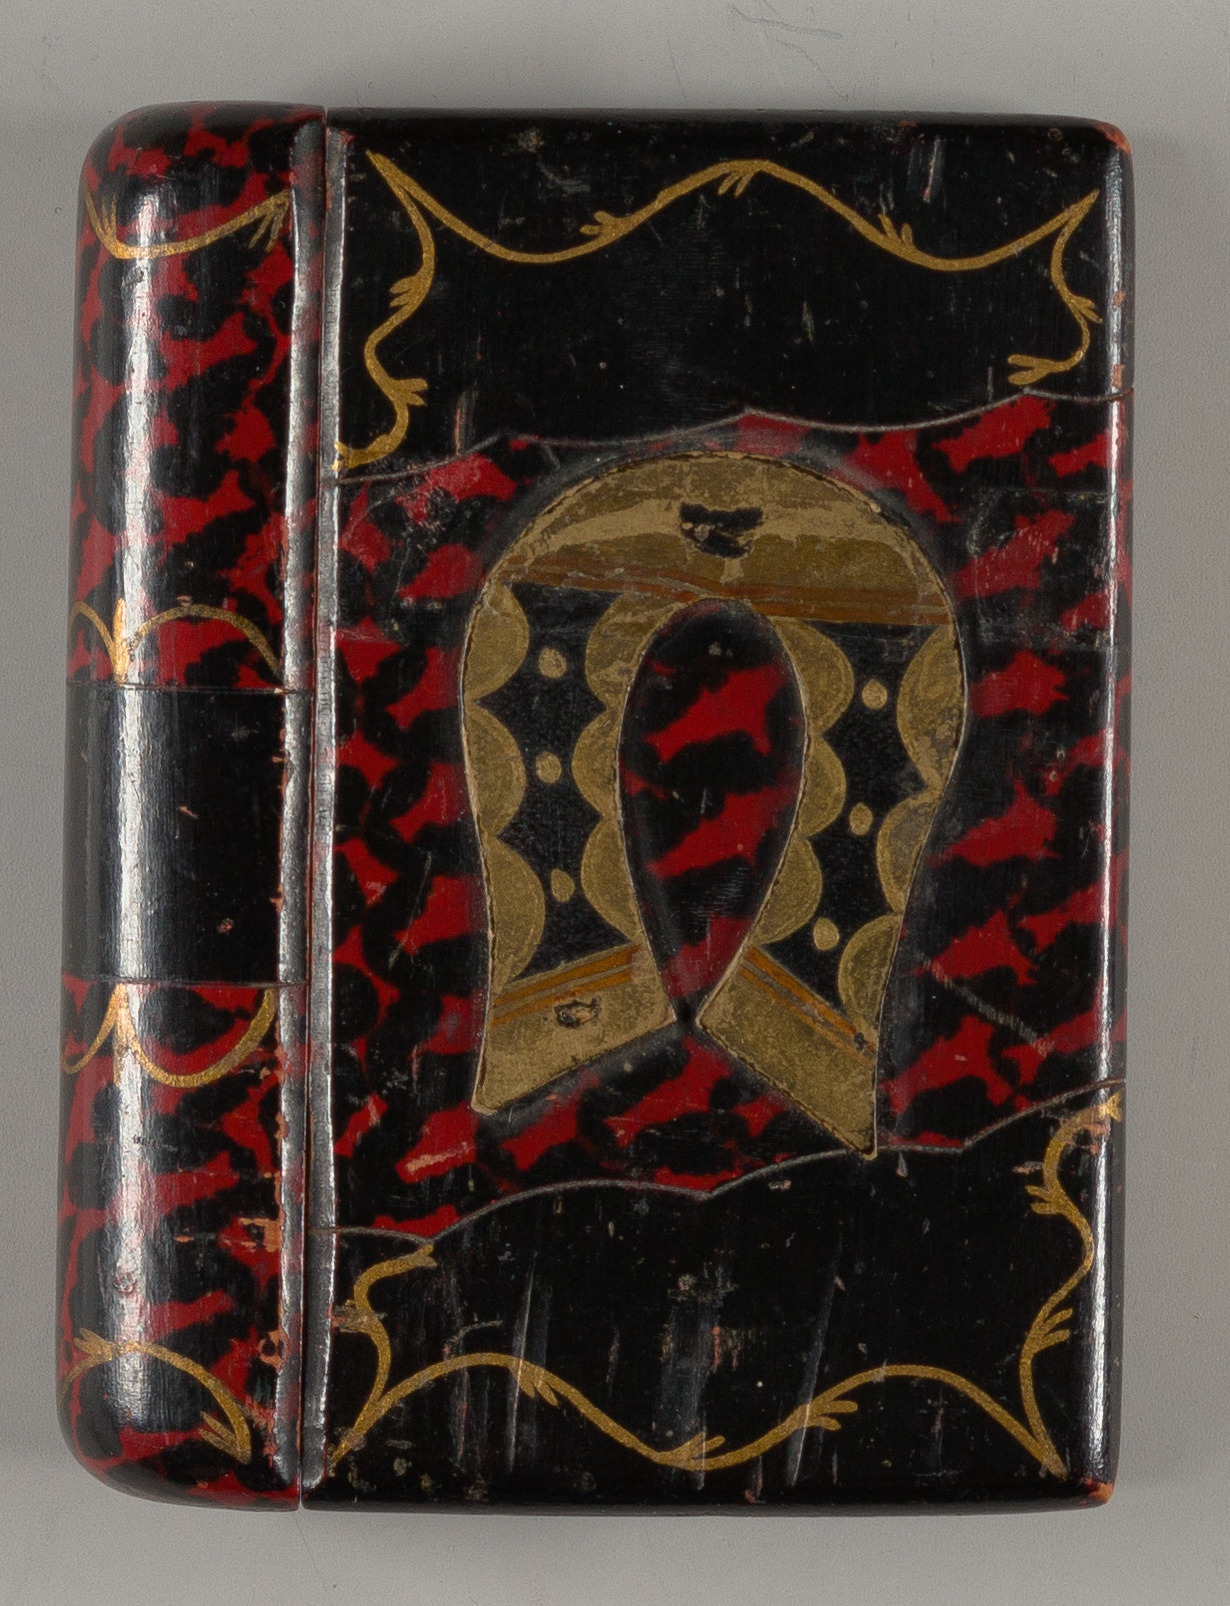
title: A good luck box with drawer in book form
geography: united states